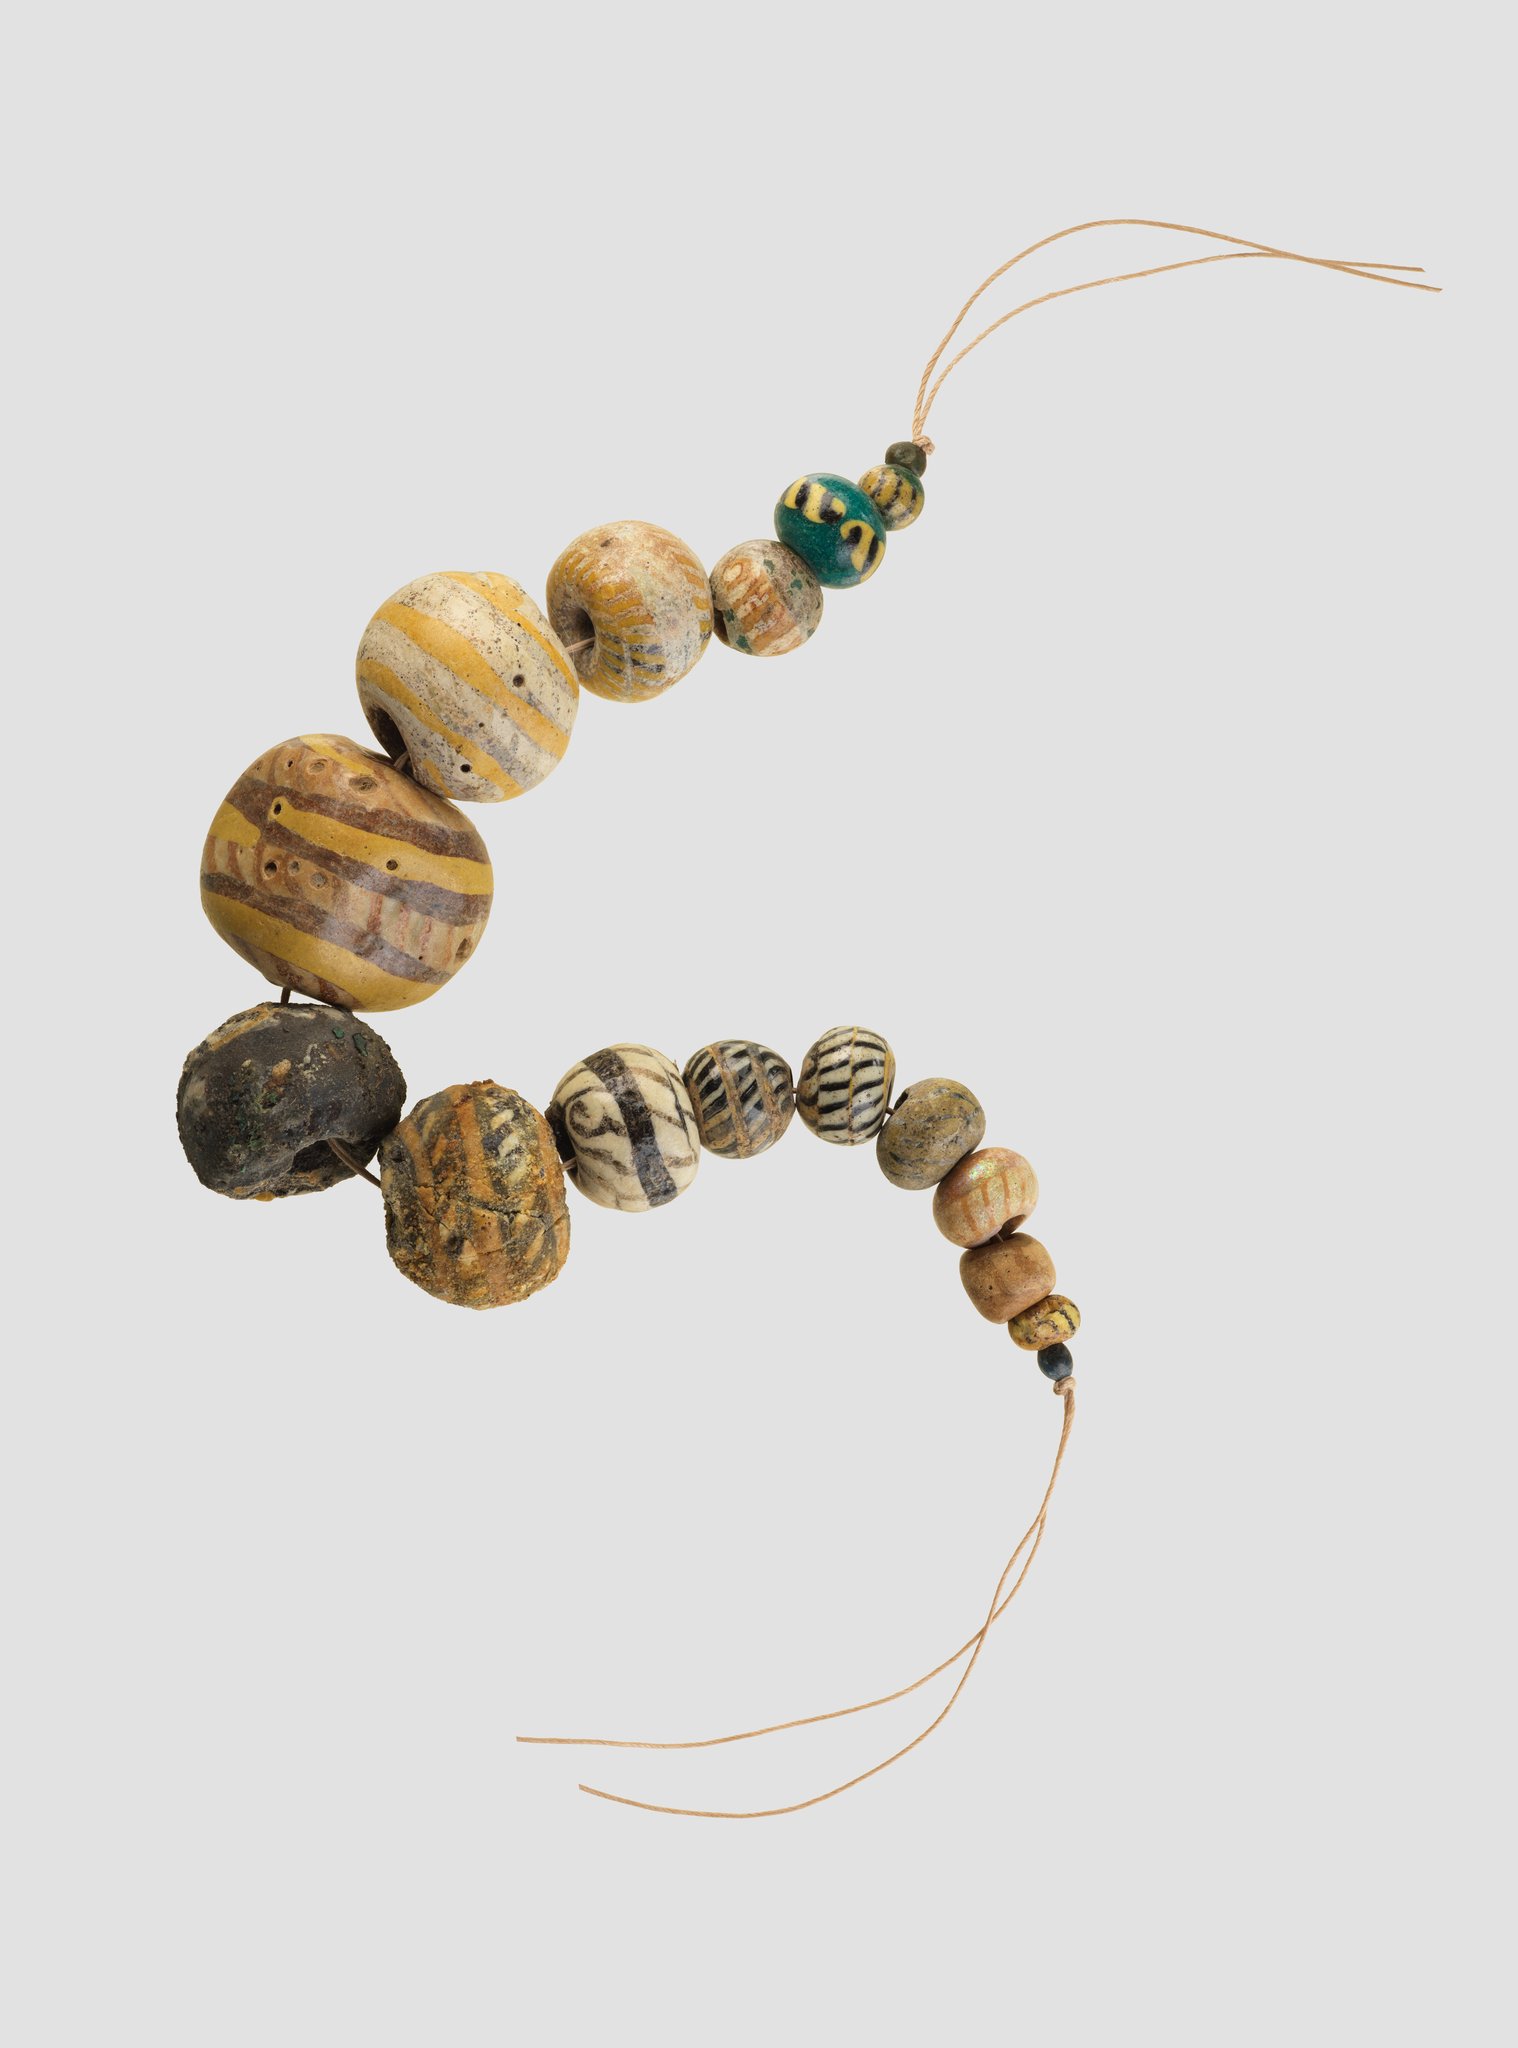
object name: bead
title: Beads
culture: iranian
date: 900-801 BCE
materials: glass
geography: iran